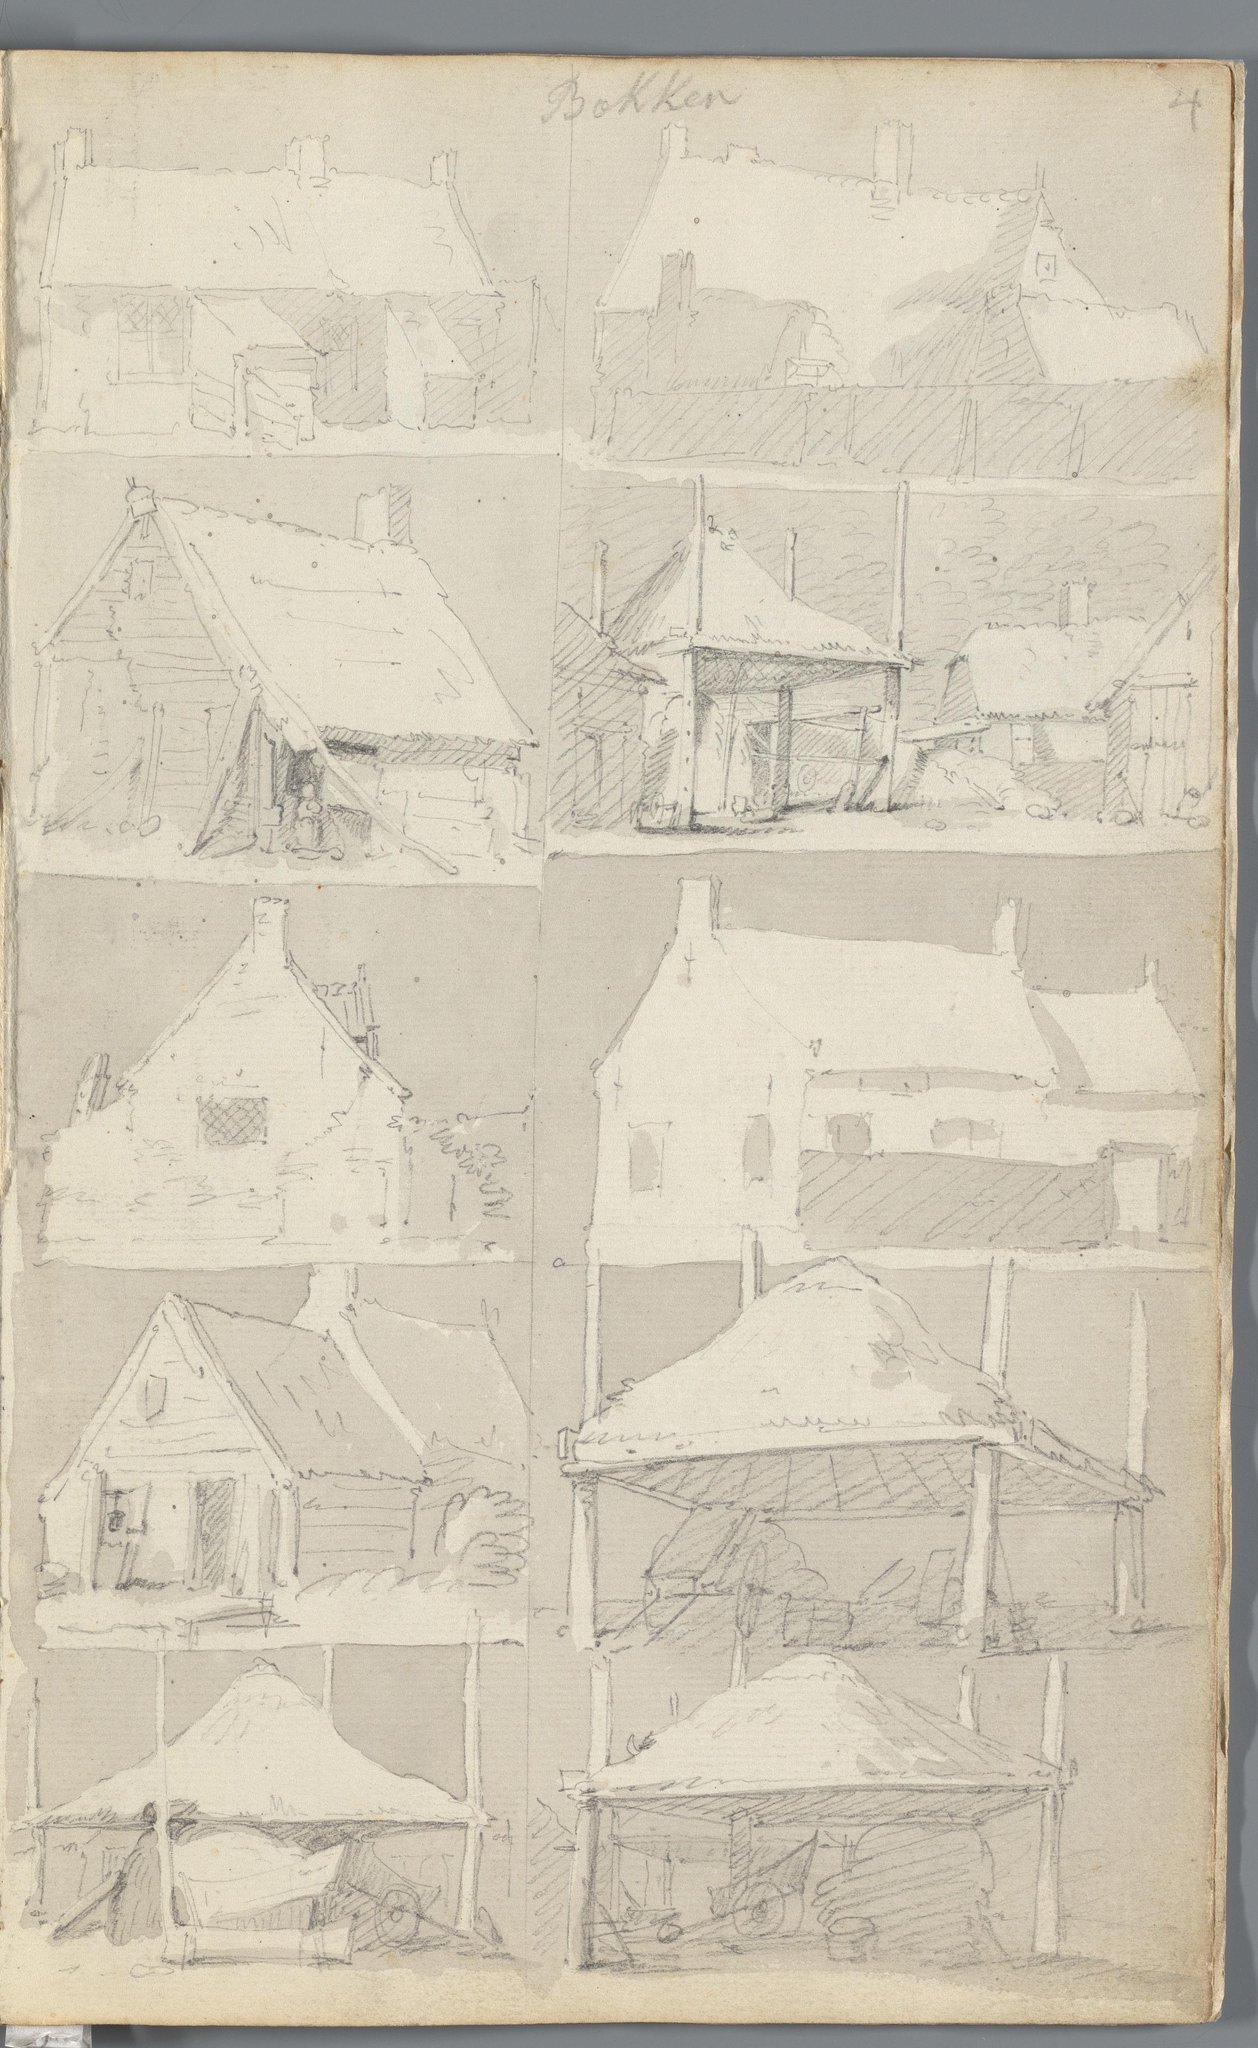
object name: sketchbook leaf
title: Boerderijen en hooimijten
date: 1780-1800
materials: ink, paper, pencil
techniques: brush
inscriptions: inscription: ‘4’, inscription: ‘Bokken’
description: Blad 7 recto uit een schetsboek met 17 bladen.